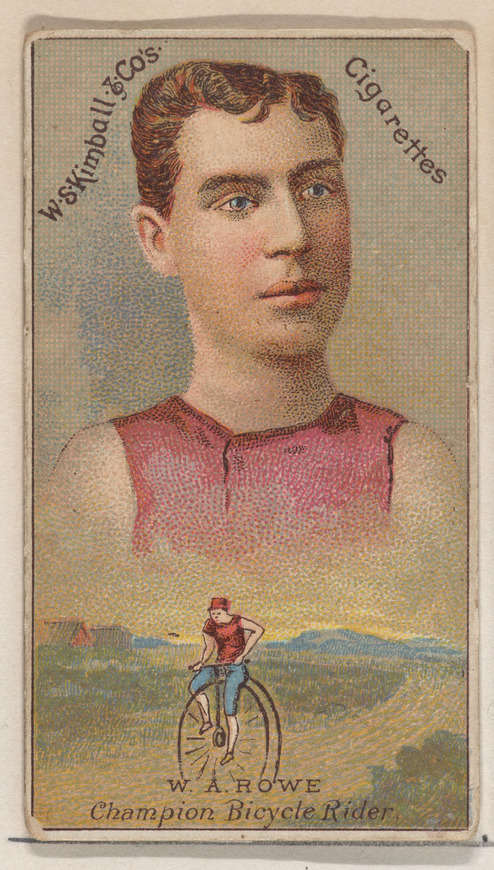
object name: print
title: W.A. Rowe, Champion Bicycle Rider, from the Champions of Games and Sports series (N184, Type 1) issued by W.S. Kimball & Co.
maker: w.s. kimball & co.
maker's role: publisher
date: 1887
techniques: color lithograph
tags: men,athletes